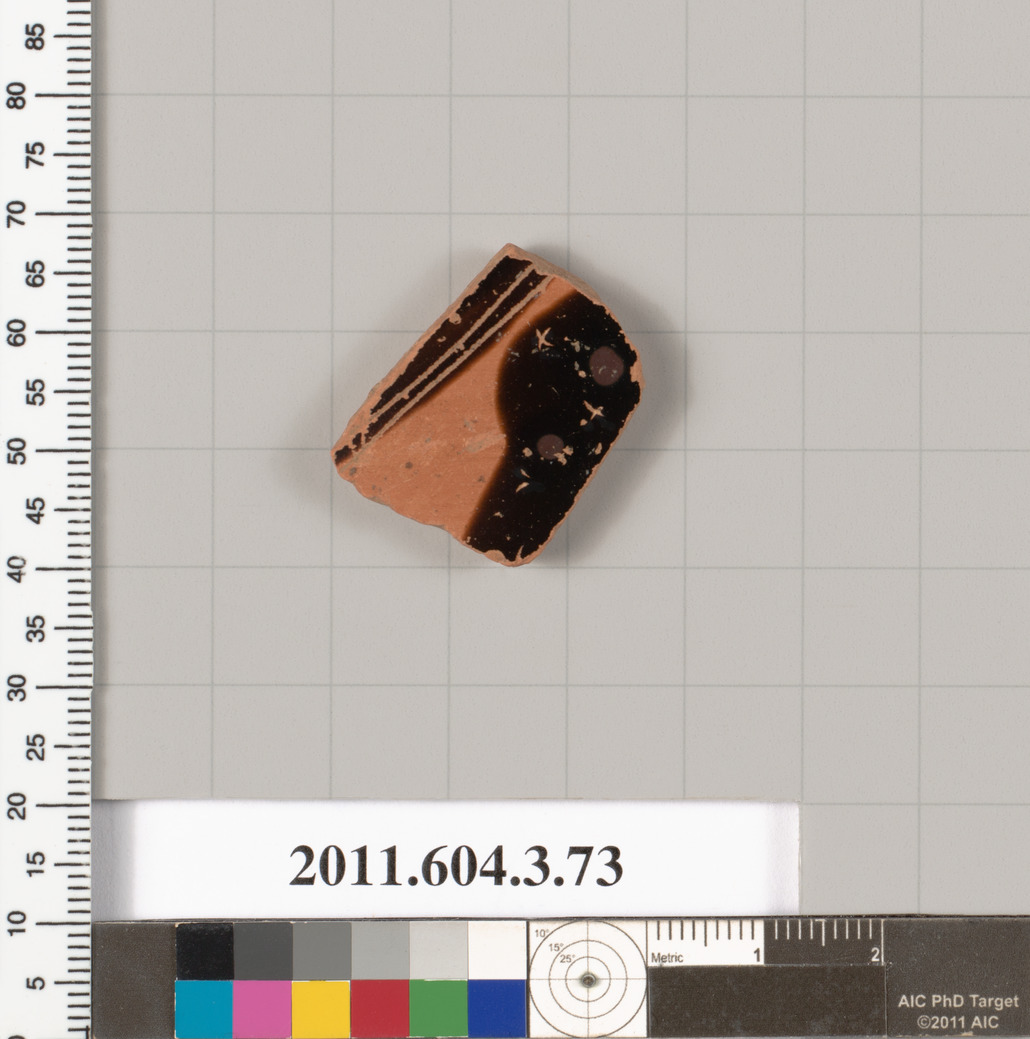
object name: amphora fragment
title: Terracotta fragment of an amphora (jar)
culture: greek, attic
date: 525-501 BCE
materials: terracotta